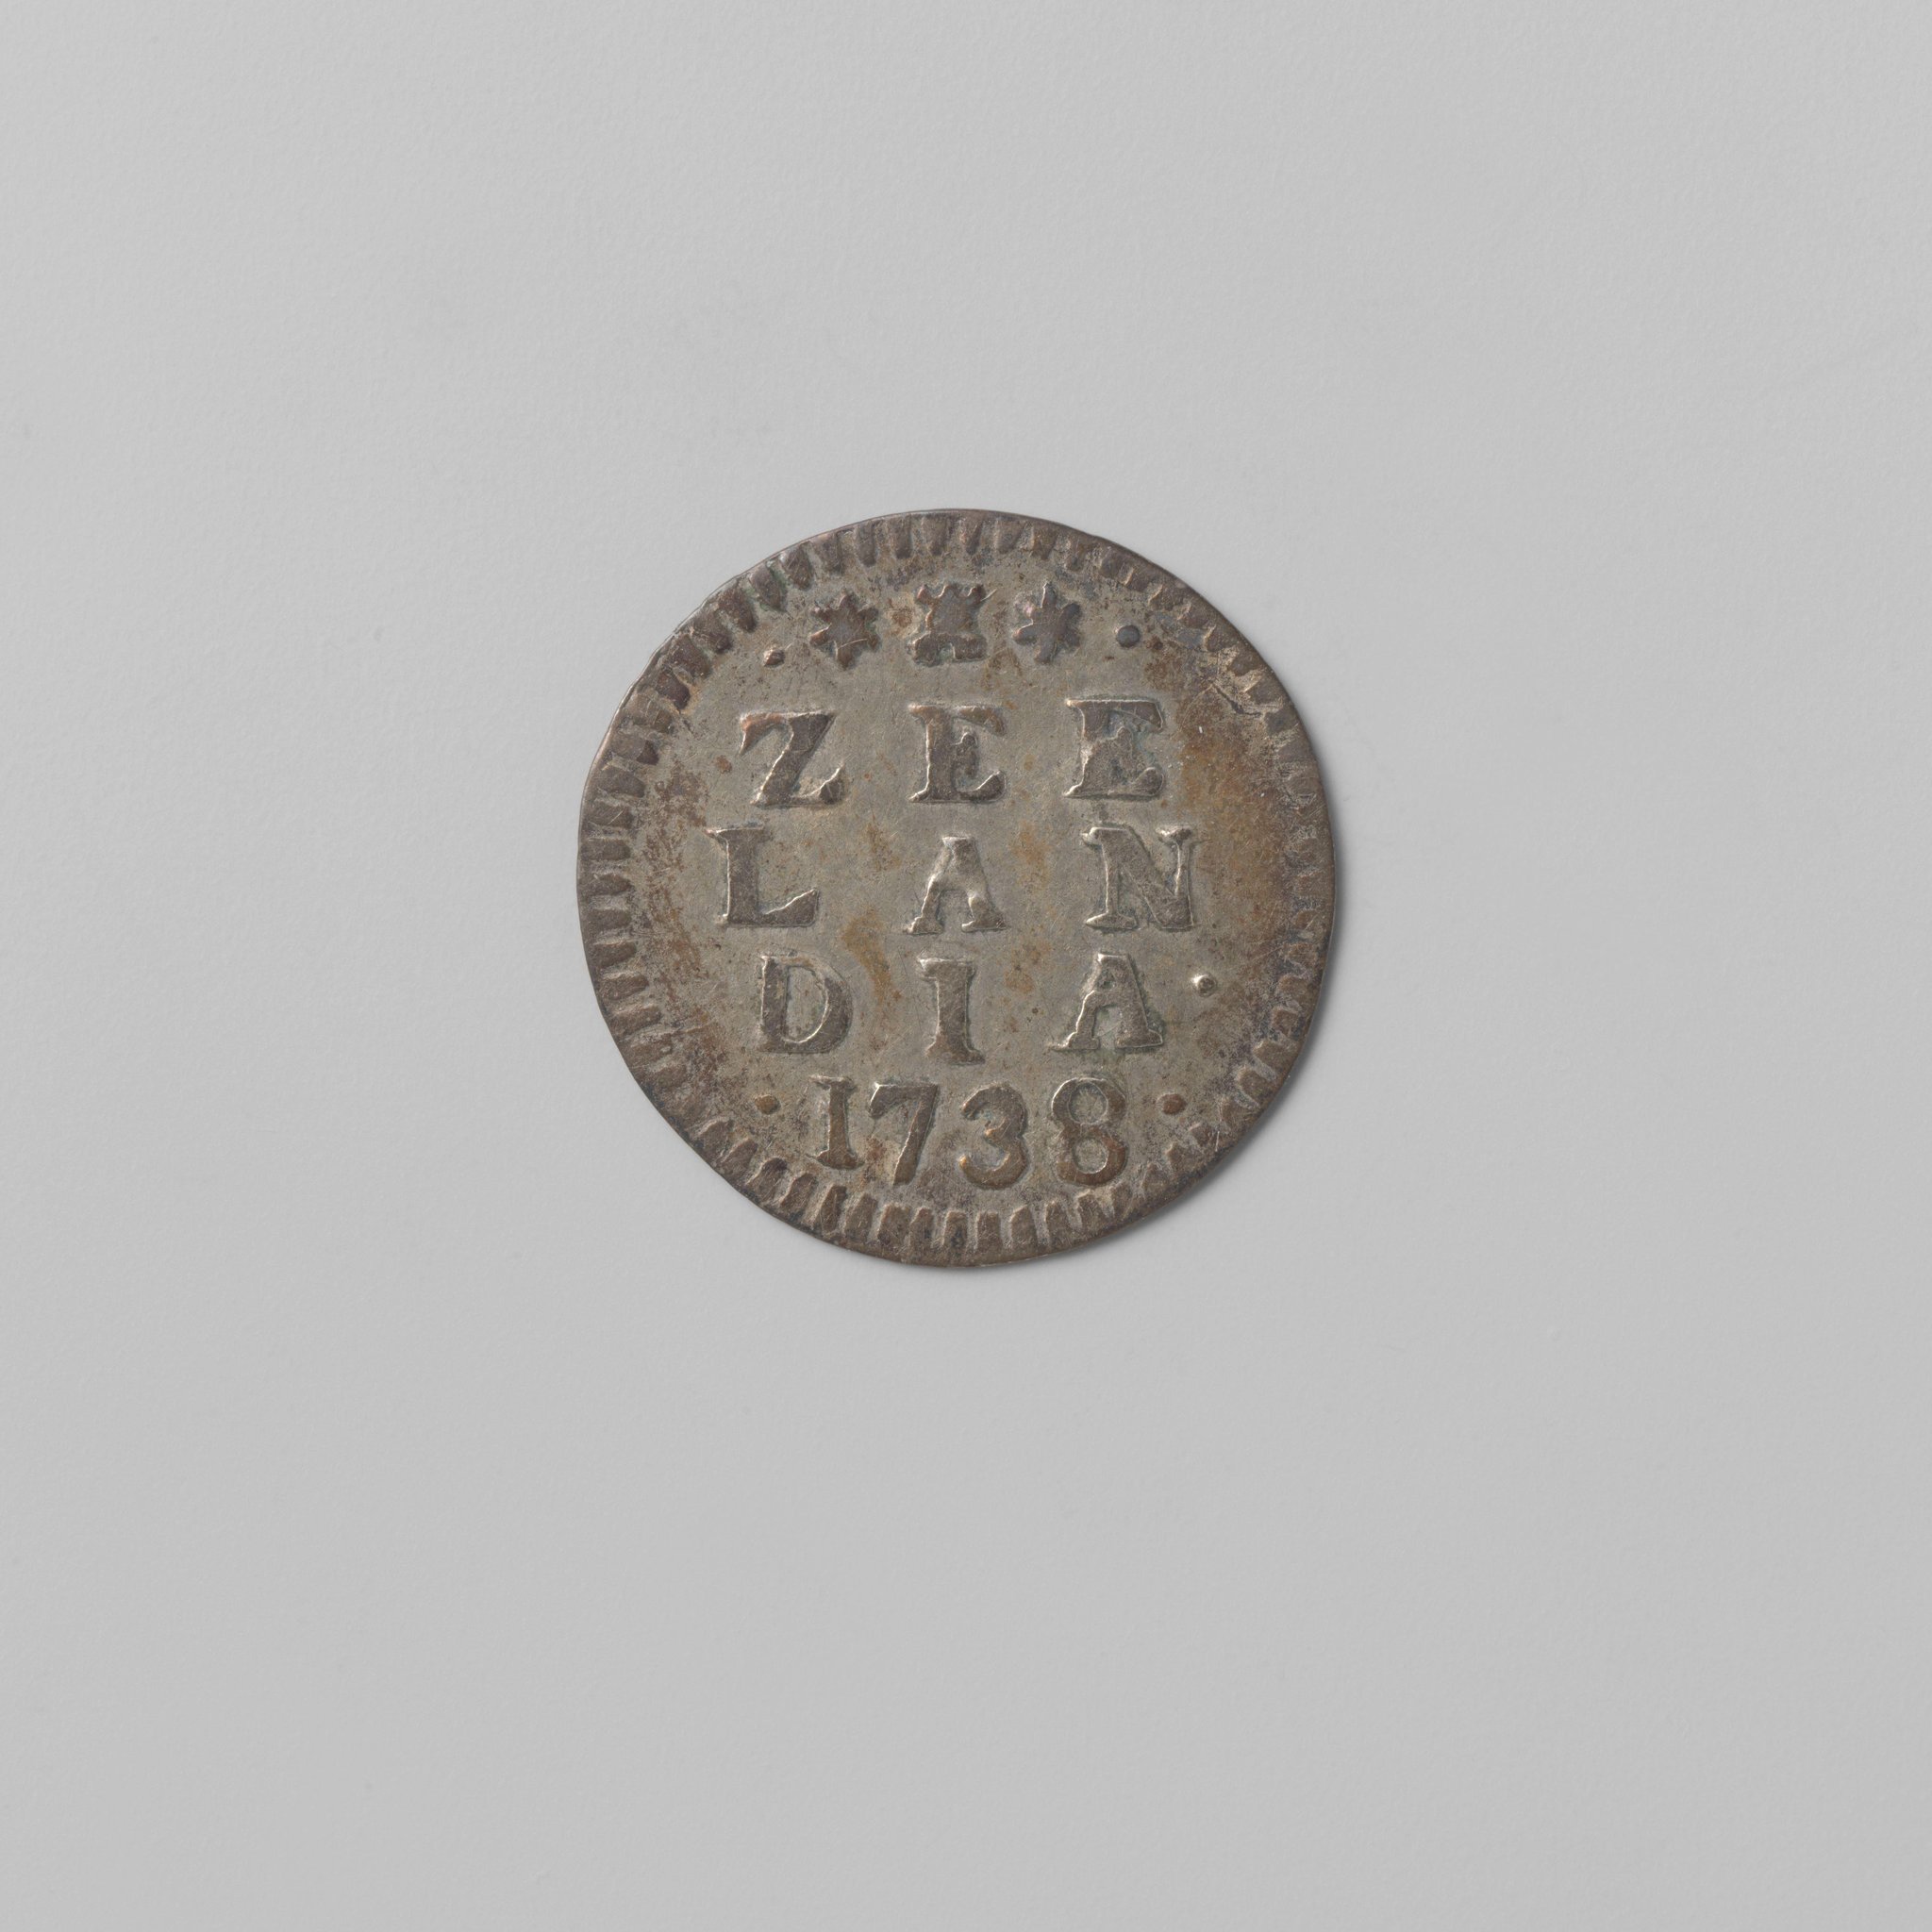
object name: coin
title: Zeeuwse stuiver, 1738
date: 1738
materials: silver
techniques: striking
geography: middelburg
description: Zilveren munt. Voorzijde: Keerzijde: opschrift in drie regels, waarboven muntteken burcht tussen twee rozetten en waaronder jaartal. Keerzijde: binnen lauwerkrans tussen waarde-aanduiding pijlenbundel.